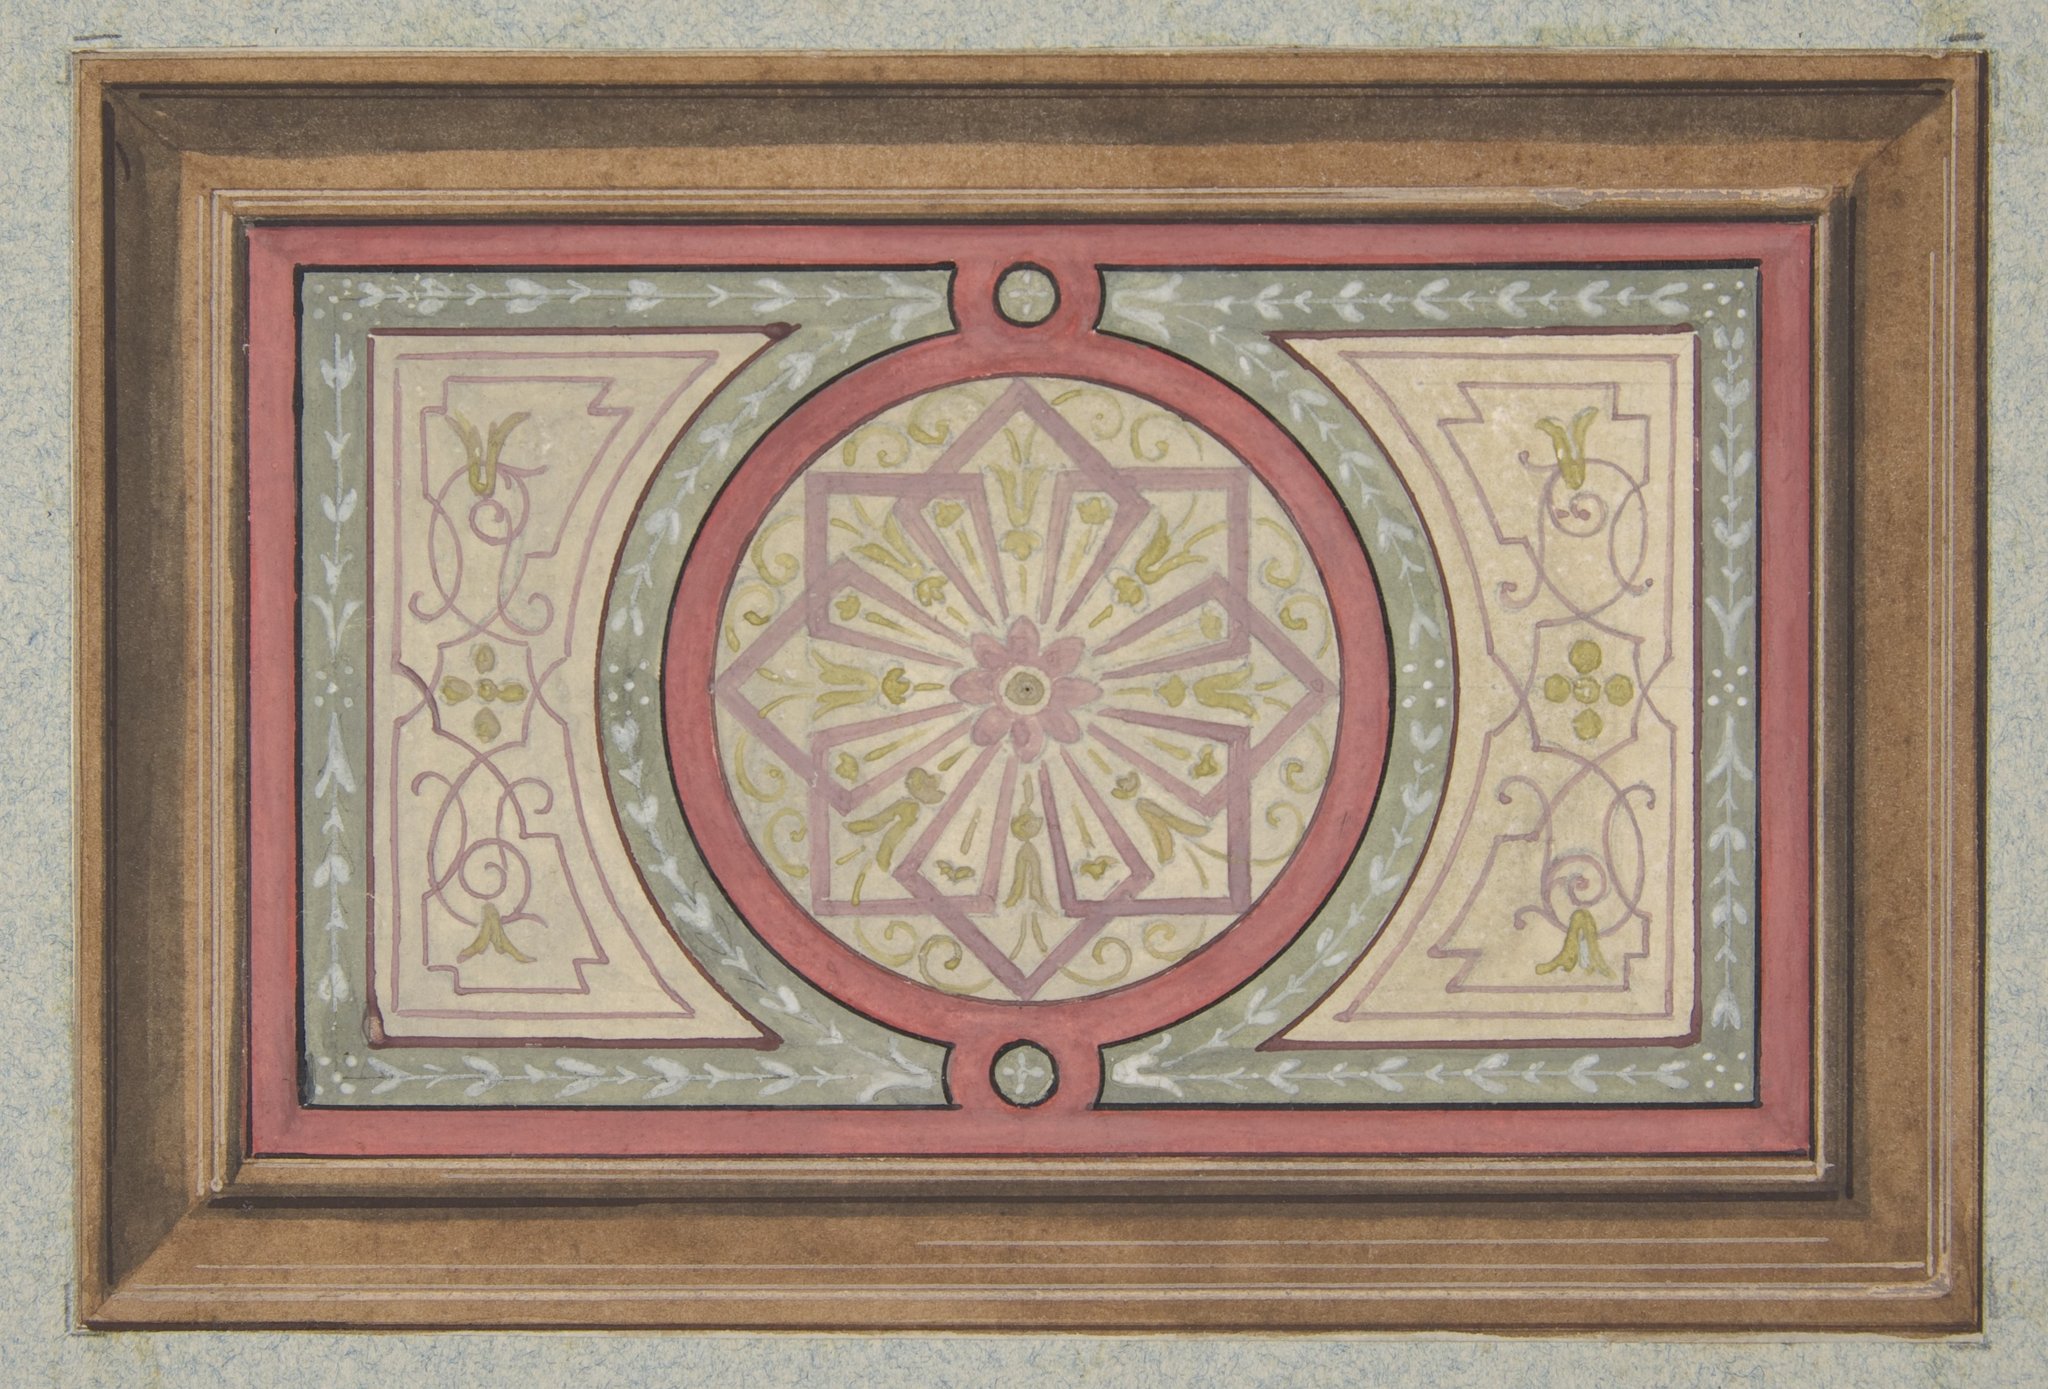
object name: drawing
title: Design for a framed panel with painted decoration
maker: jules-edmond-charles lachaise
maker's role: artist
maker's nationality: french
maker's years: 1897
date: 1830-1897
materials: gouache, graphite, ink, paper, watercolor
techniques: pen